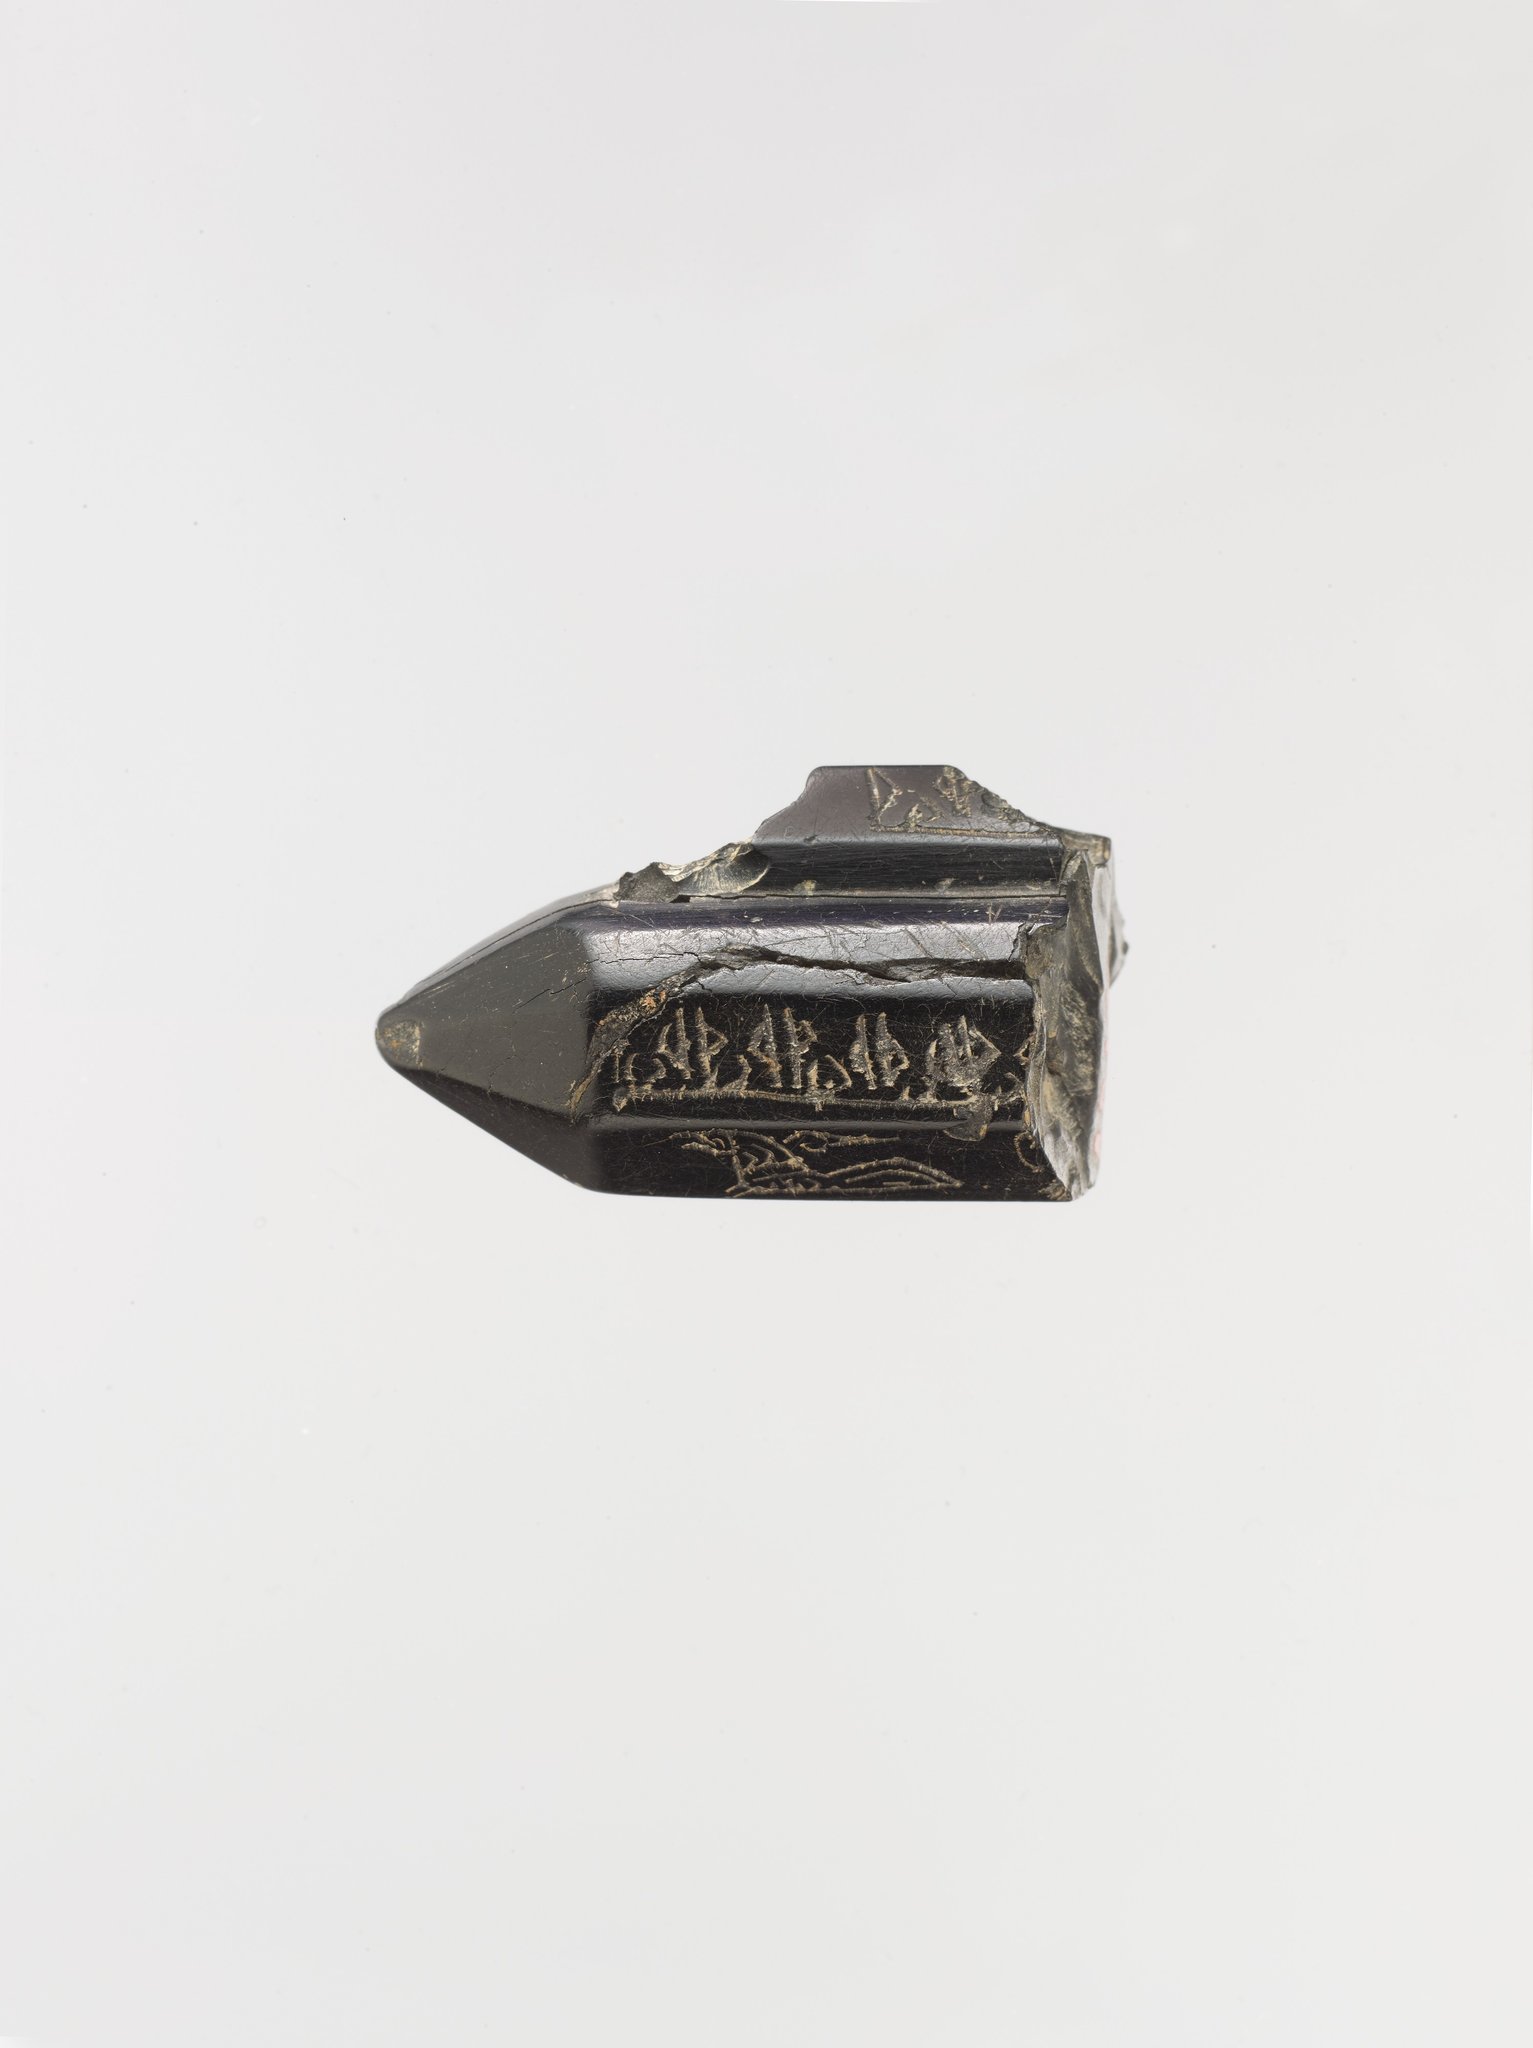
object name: pendant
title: Cylindrical Pendant with Magical Writing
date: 801-1000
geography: iran